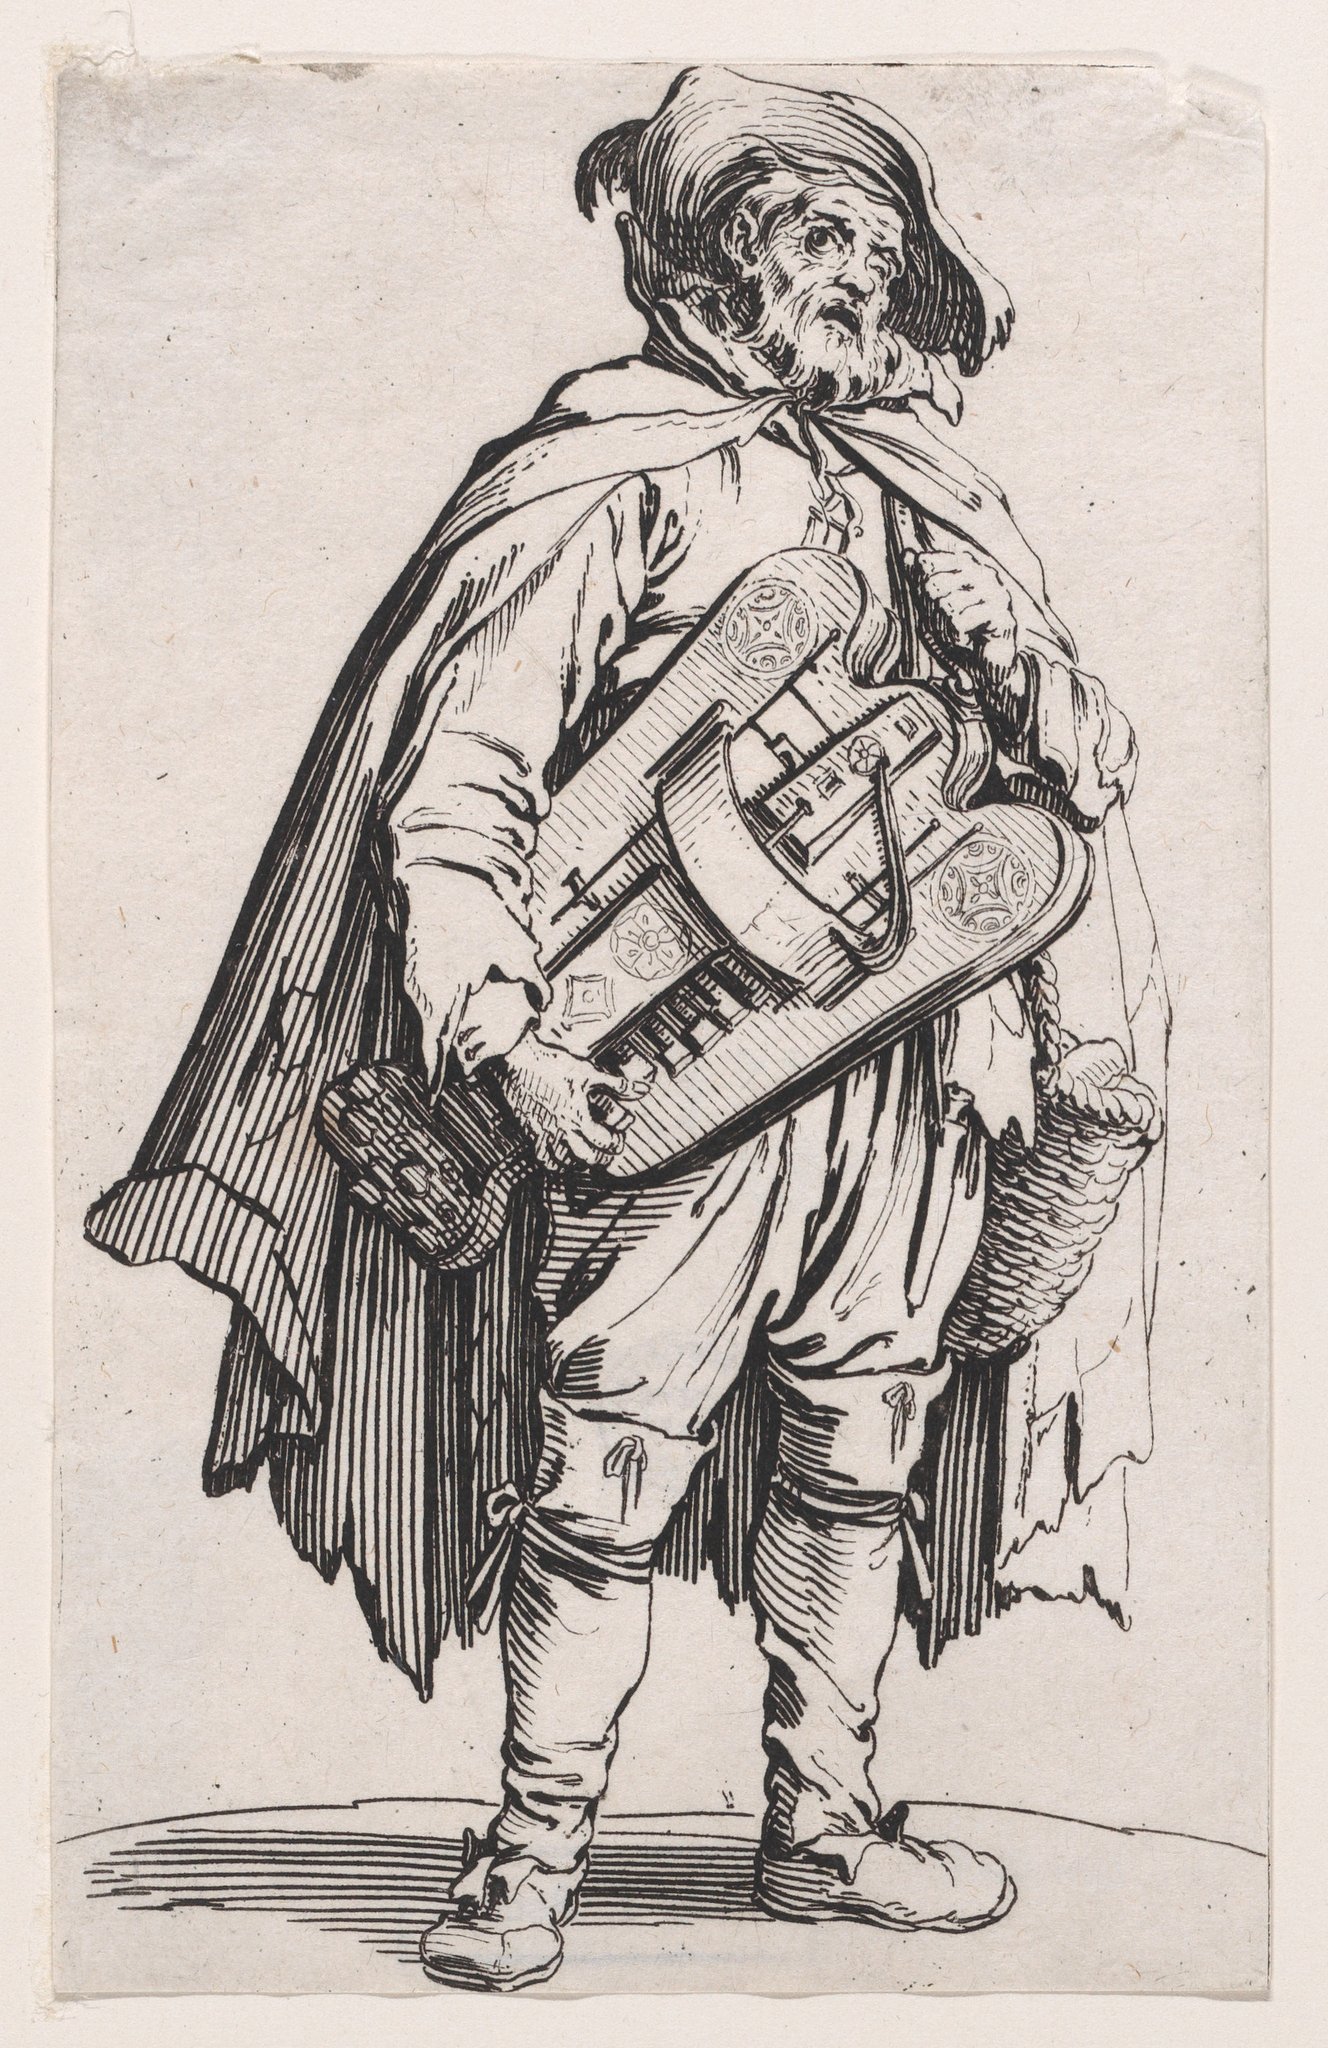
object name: print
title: Le Joueur de Vielle (The Hurdy-Gurdy Player), from "Les Gueux suite appelée aussi Les Mendiants, Les Baroni, ou Les Barons" (The Beggars, also called the Barons)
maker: jacques callot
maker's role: artist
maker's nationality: french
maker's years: 1592-1635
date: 1623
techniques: etching